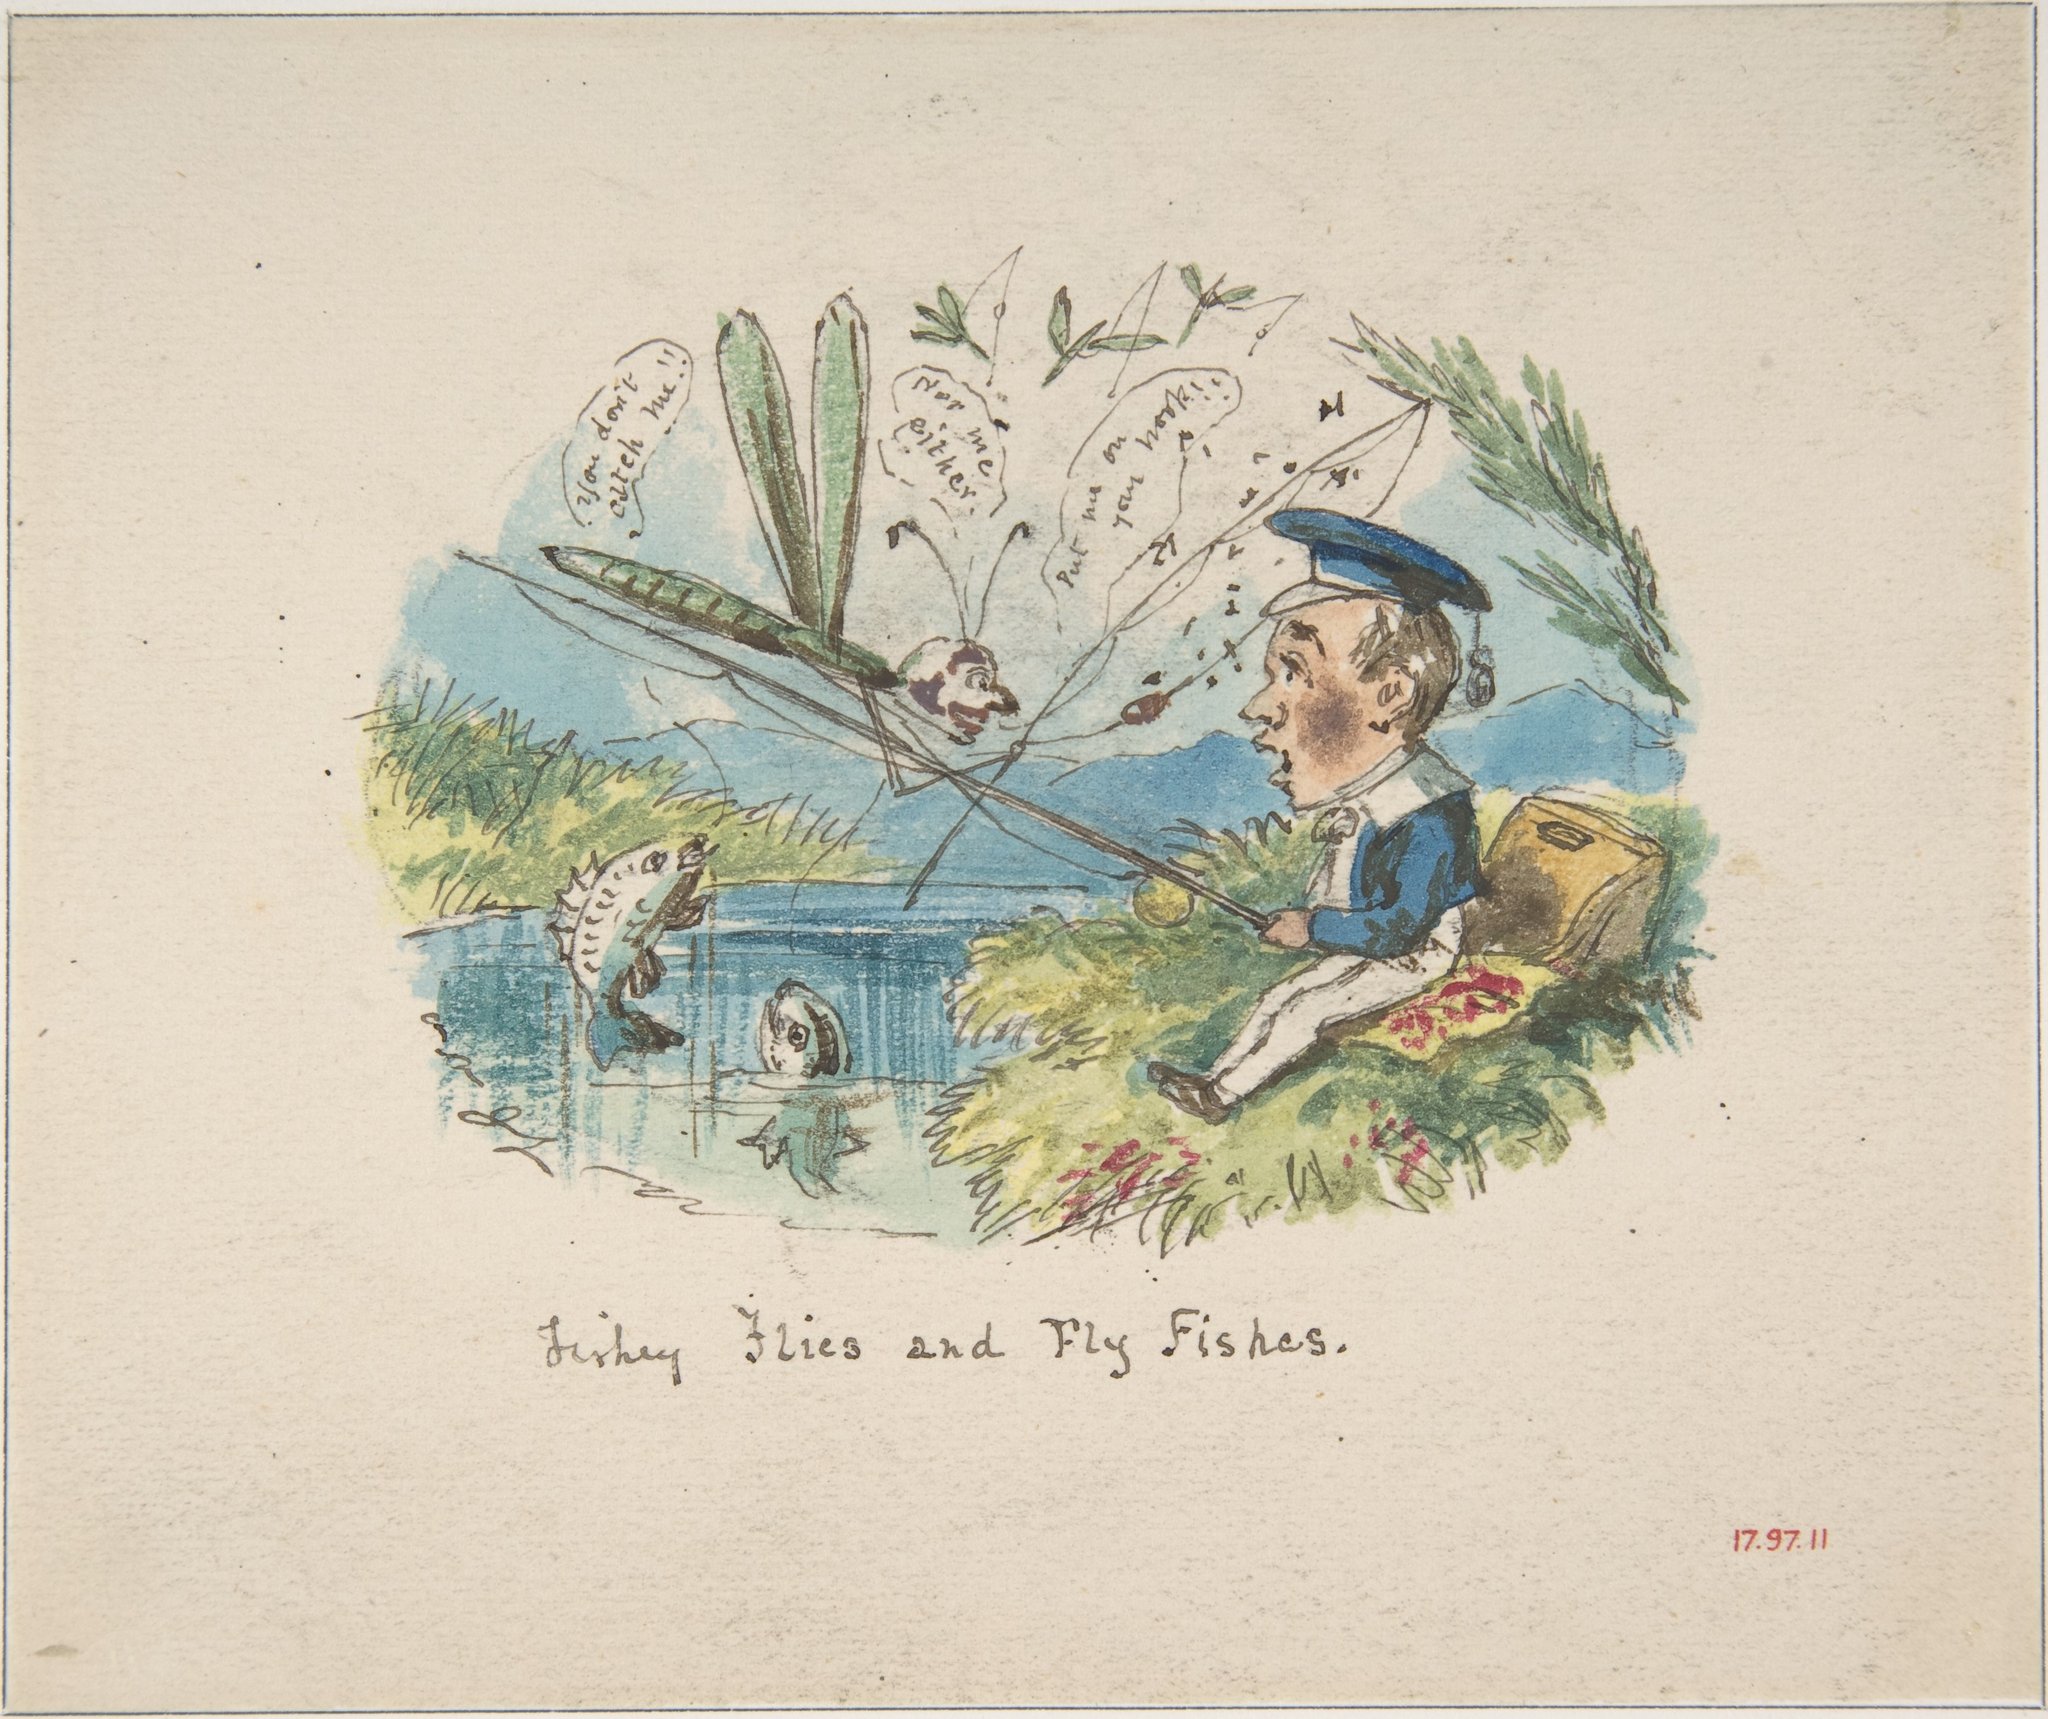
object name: drawing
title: Fishey Flies and Fly Fishes (recto); Typeface Designs (verso)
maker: john leech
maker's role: artist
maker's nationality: british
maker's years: 1817-1864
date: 1837-1899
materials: graphite, ink, watercolor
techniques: pen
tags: men,fishing,fish,dragonflies